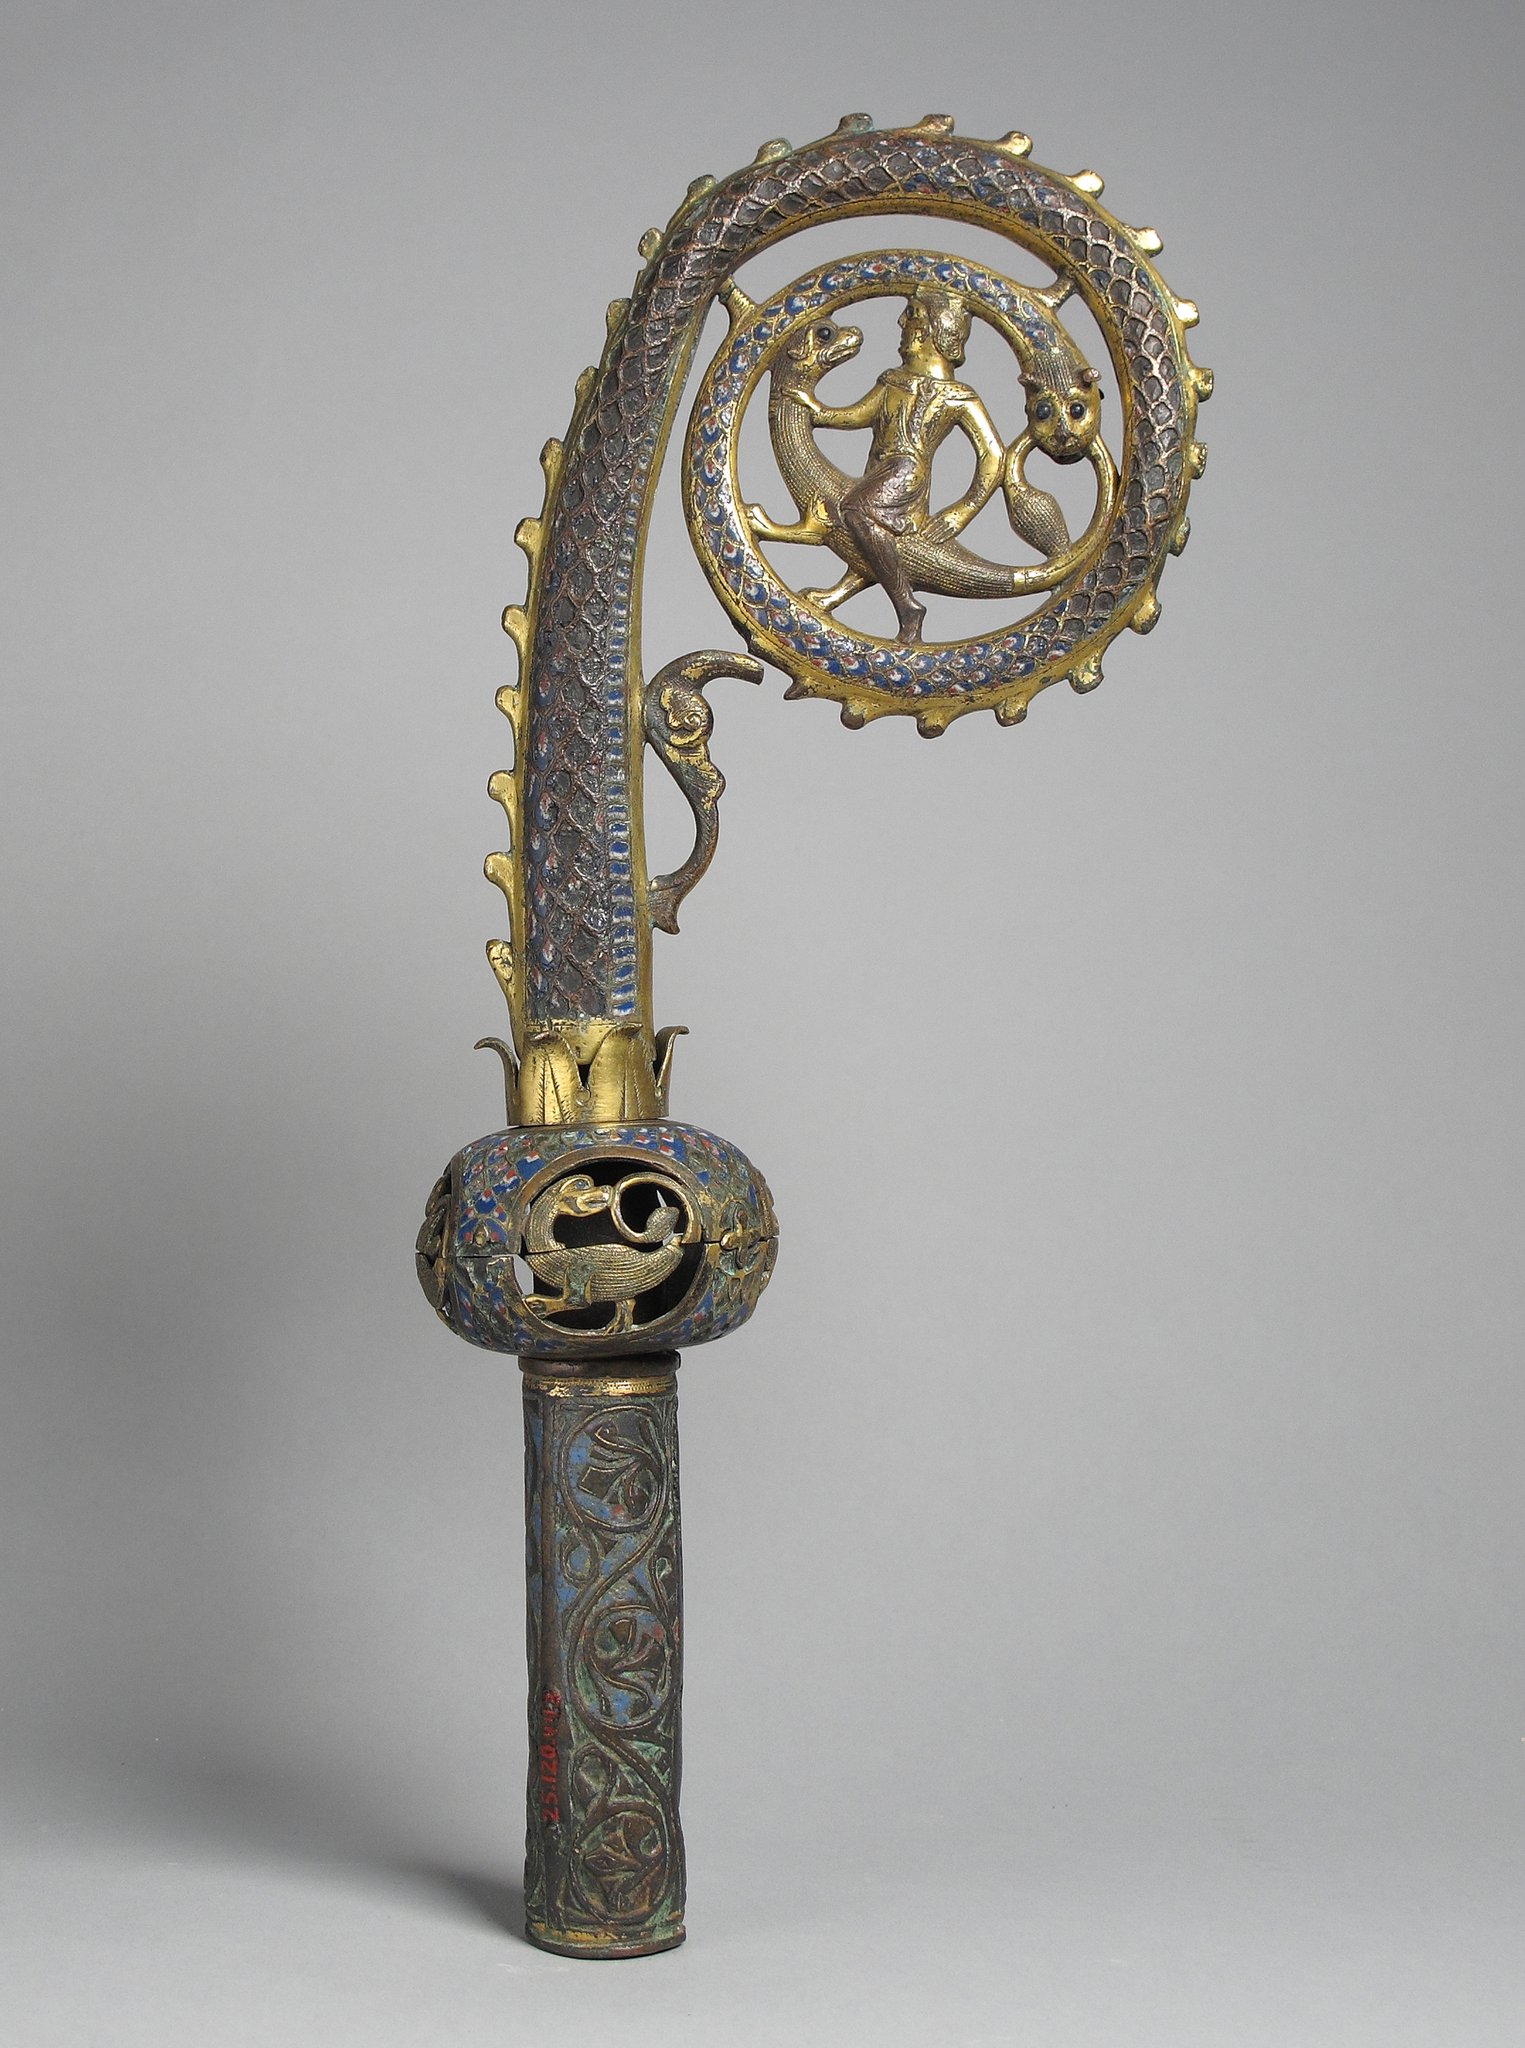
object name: crozier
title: Head of a Crozier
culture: french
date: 1210-1215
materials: gilt copper, enamel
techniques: enamel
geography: france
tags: men,dragons